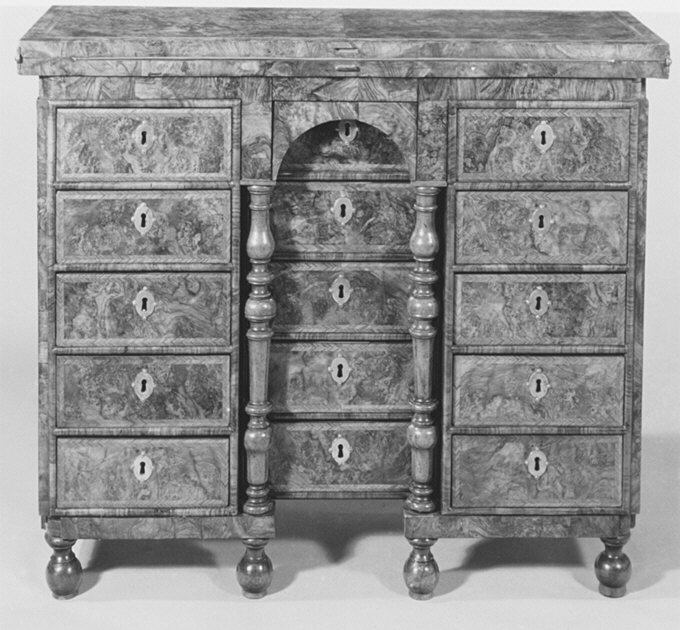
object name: writing table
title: Bachelor chest-cum-writing table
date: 1700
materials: wood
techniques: veneering